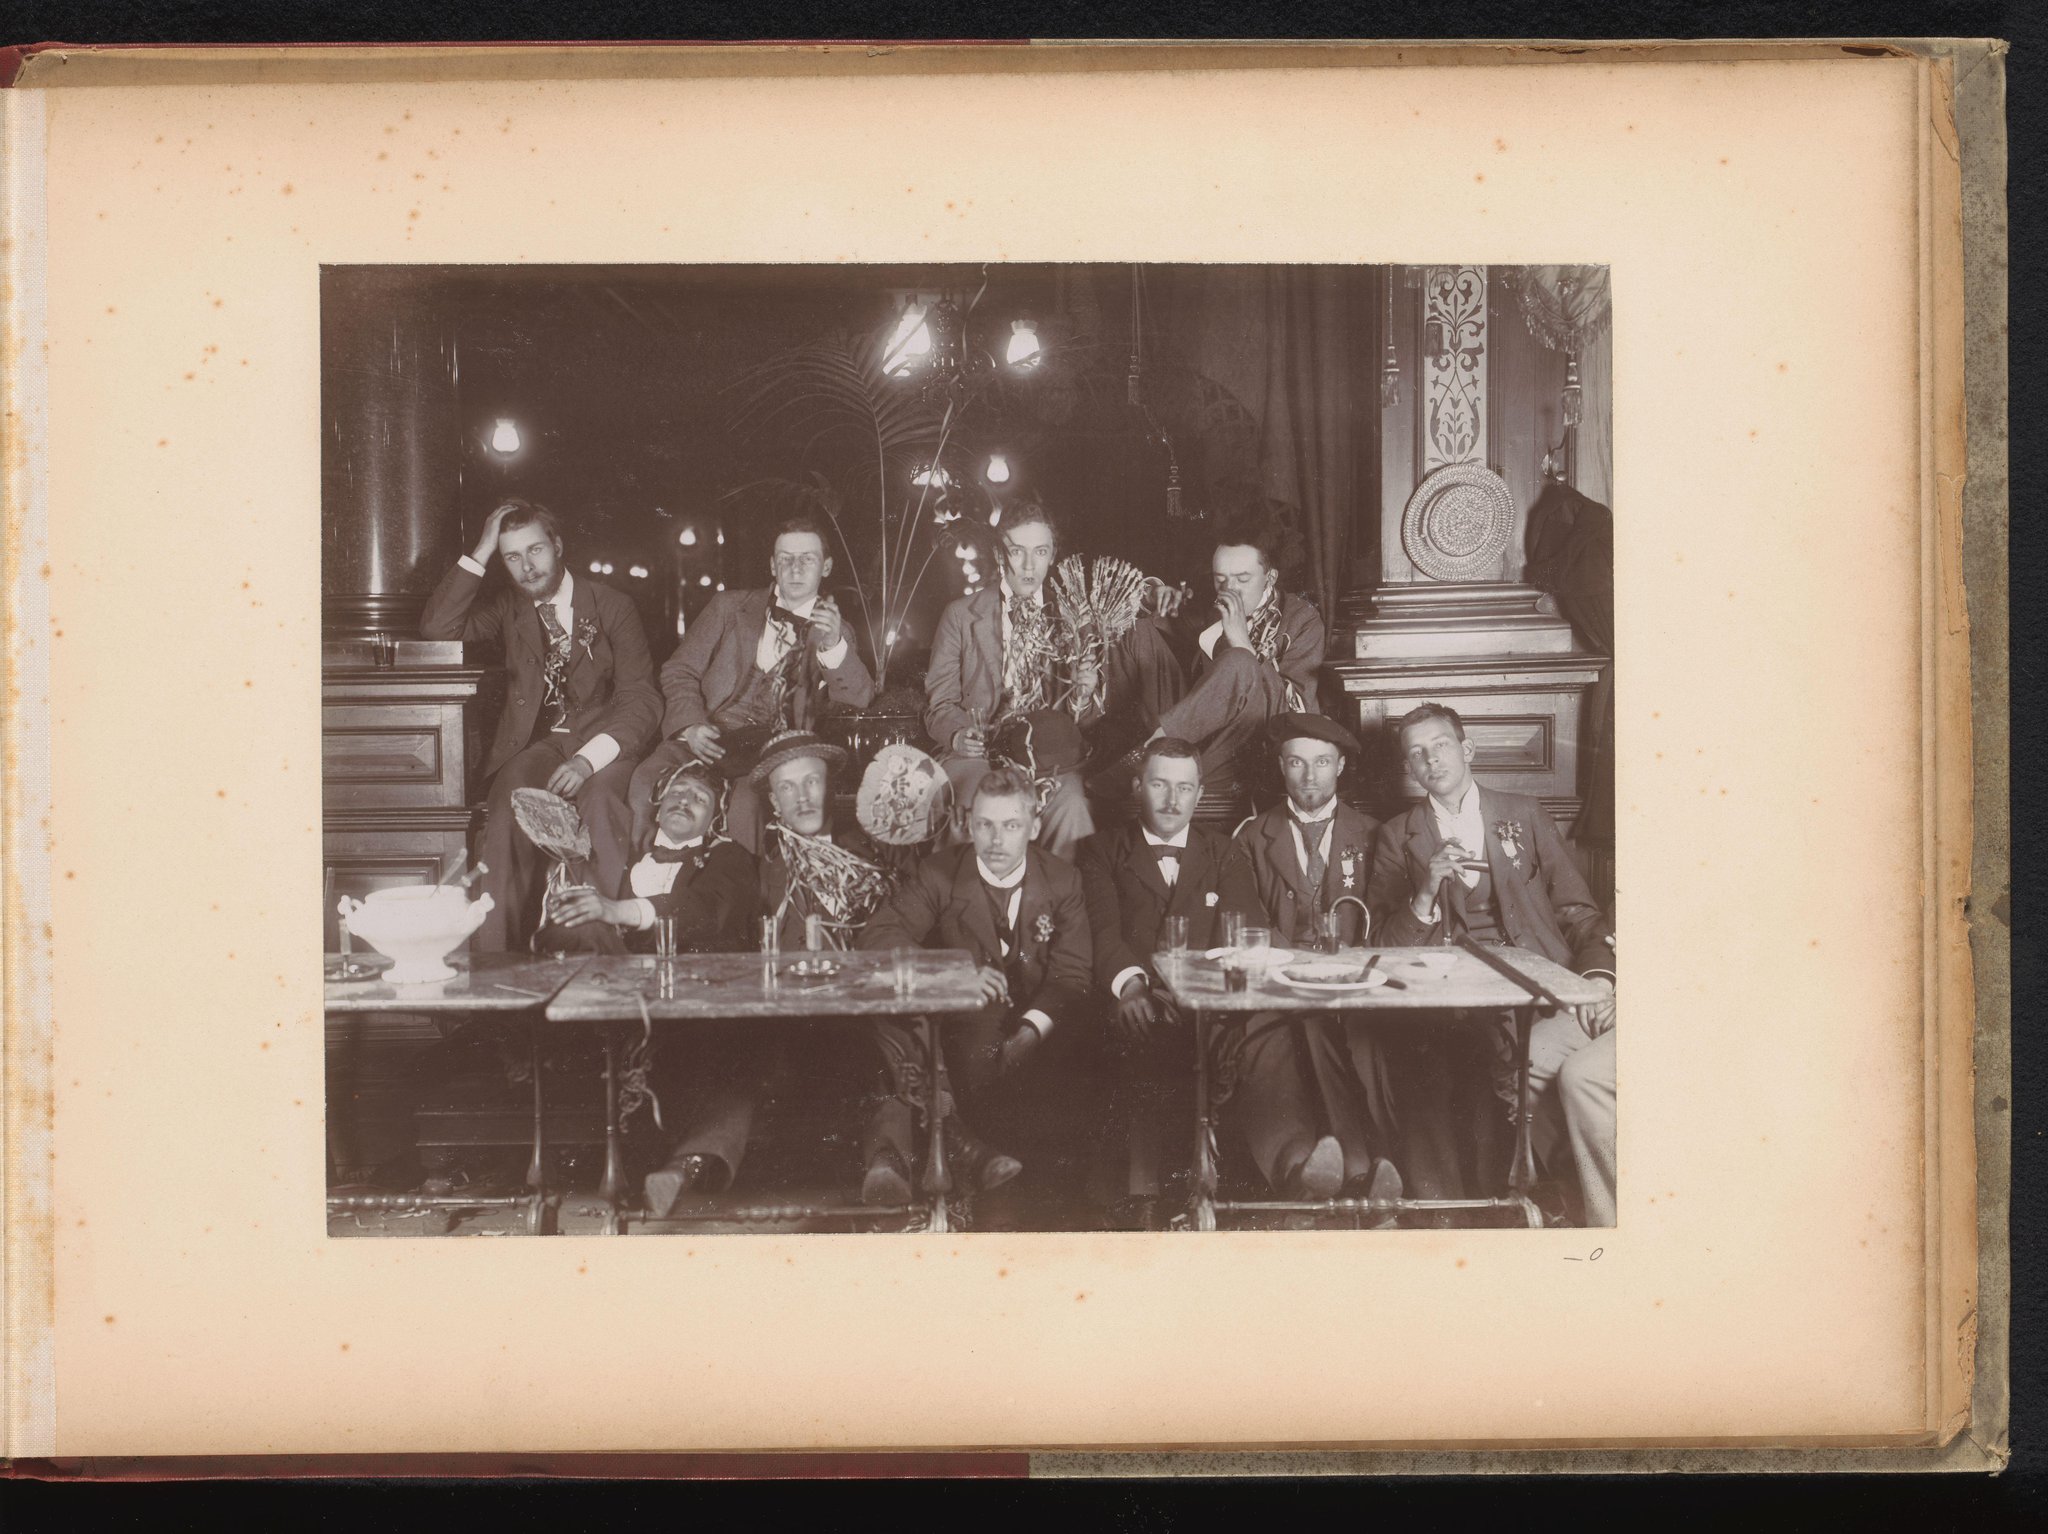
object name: album leaf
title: Groepsportret van leden van het Amsterdamsch Studenten Corps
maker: nicolaas schuitvlot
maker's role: fotograaf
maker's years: 1859-1947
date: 1806-1897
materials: cardboard, photographic support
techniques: collodion silver print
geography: netherlands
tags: students' organization, anonymous historical persons portrayed in a group, in a group-portrait, netherlands